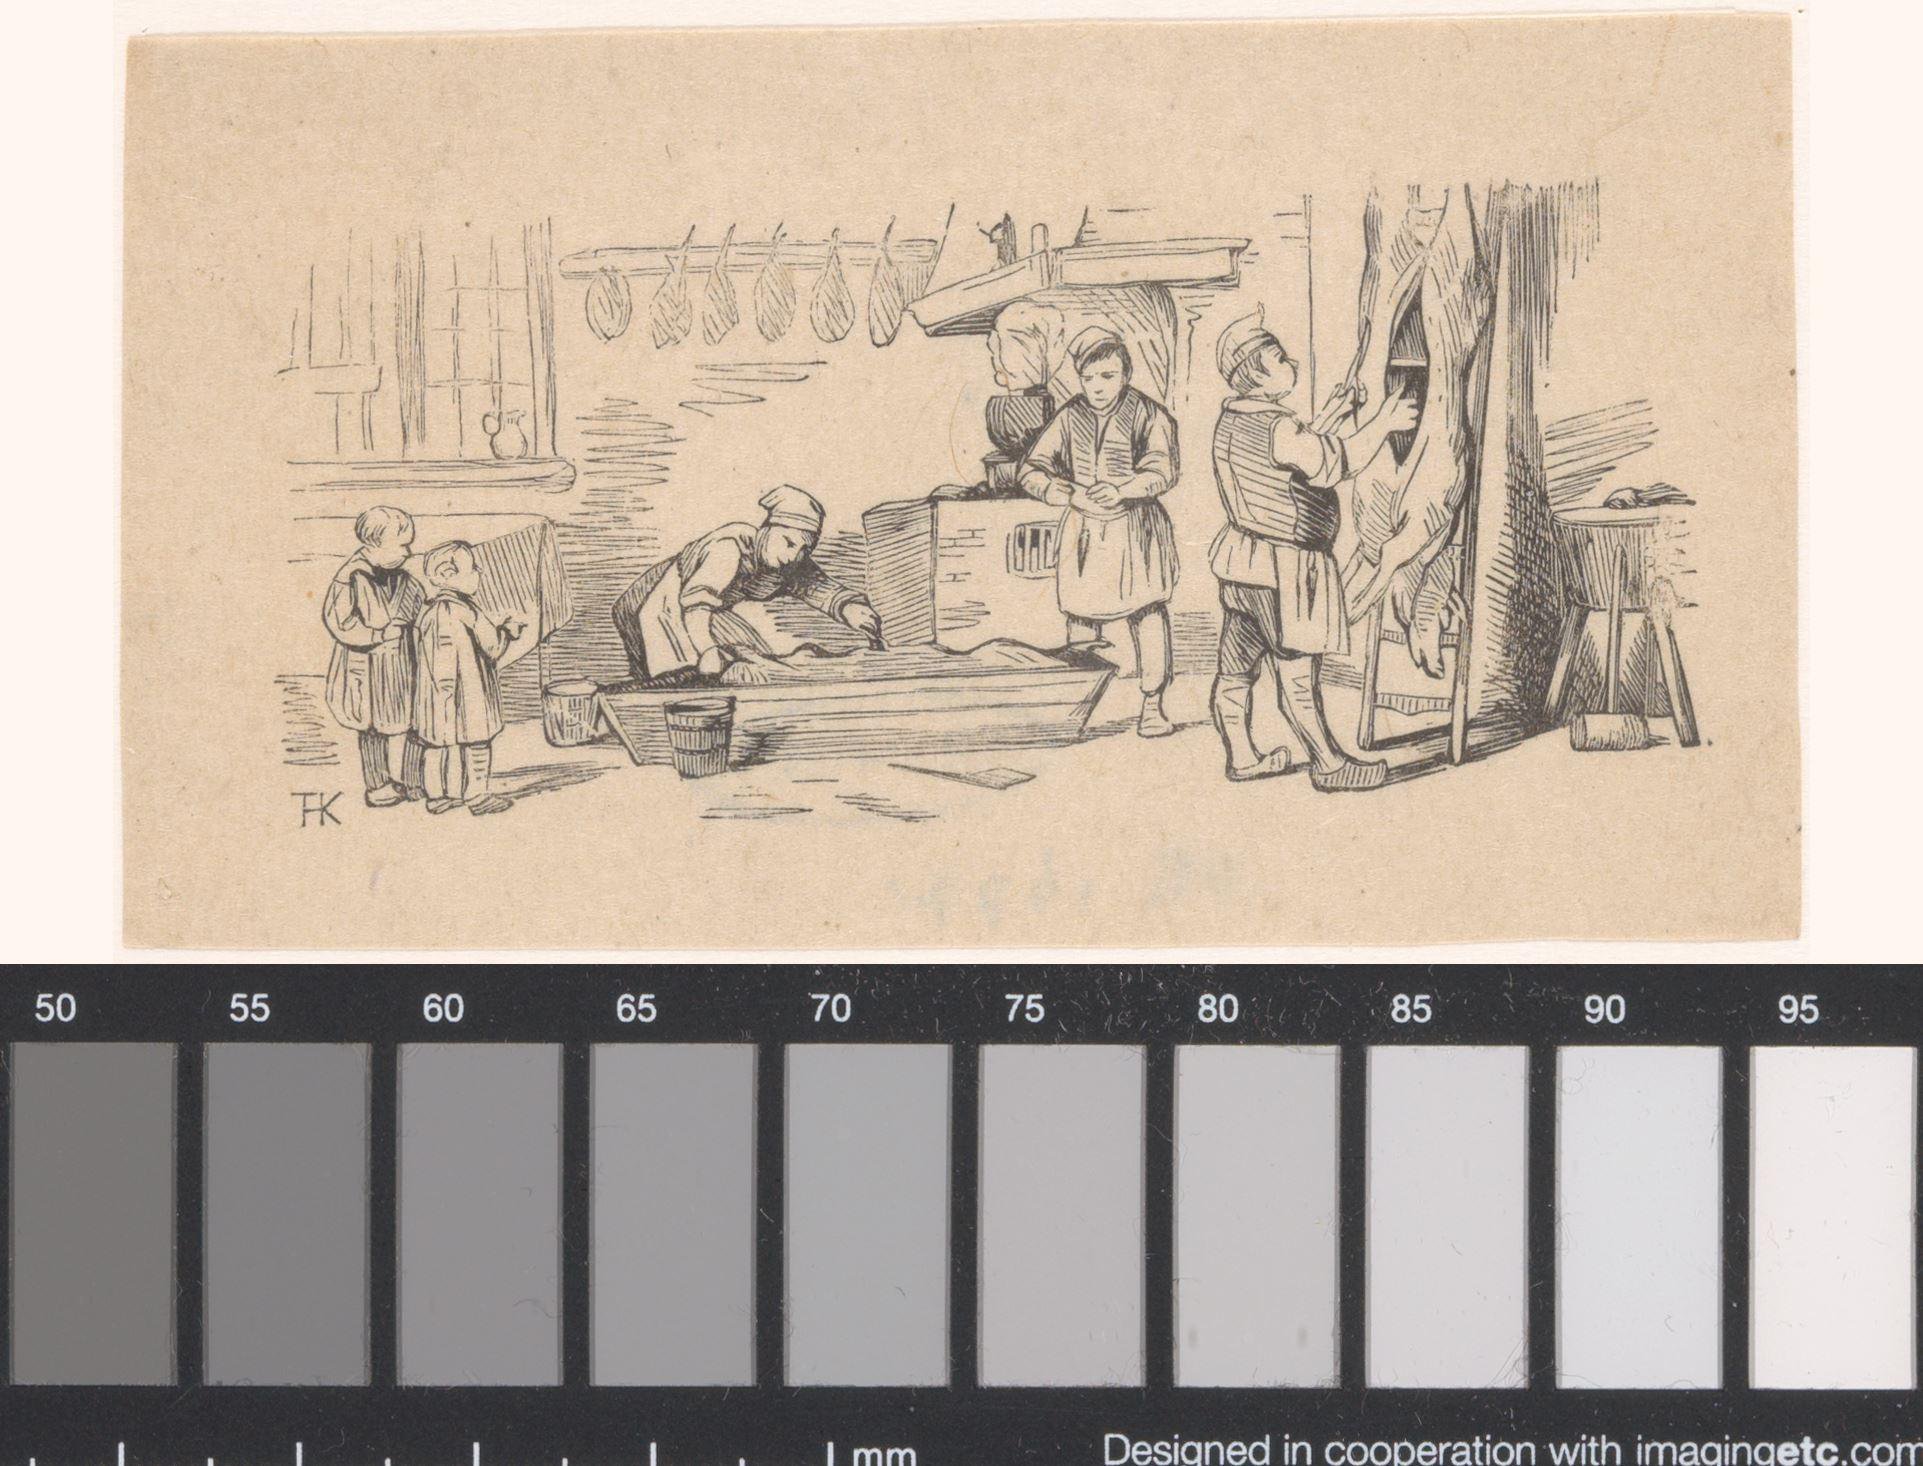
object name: print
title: Figuren in een keuken waarin een varken wordt uitgebeend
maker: theodorus henricus kerstel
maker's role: print maker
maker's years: 1859-1936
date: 1869-1936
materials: paper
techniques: line block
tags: kitchen, pig, cutting meat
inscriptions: collector's mark: Lugt 2228